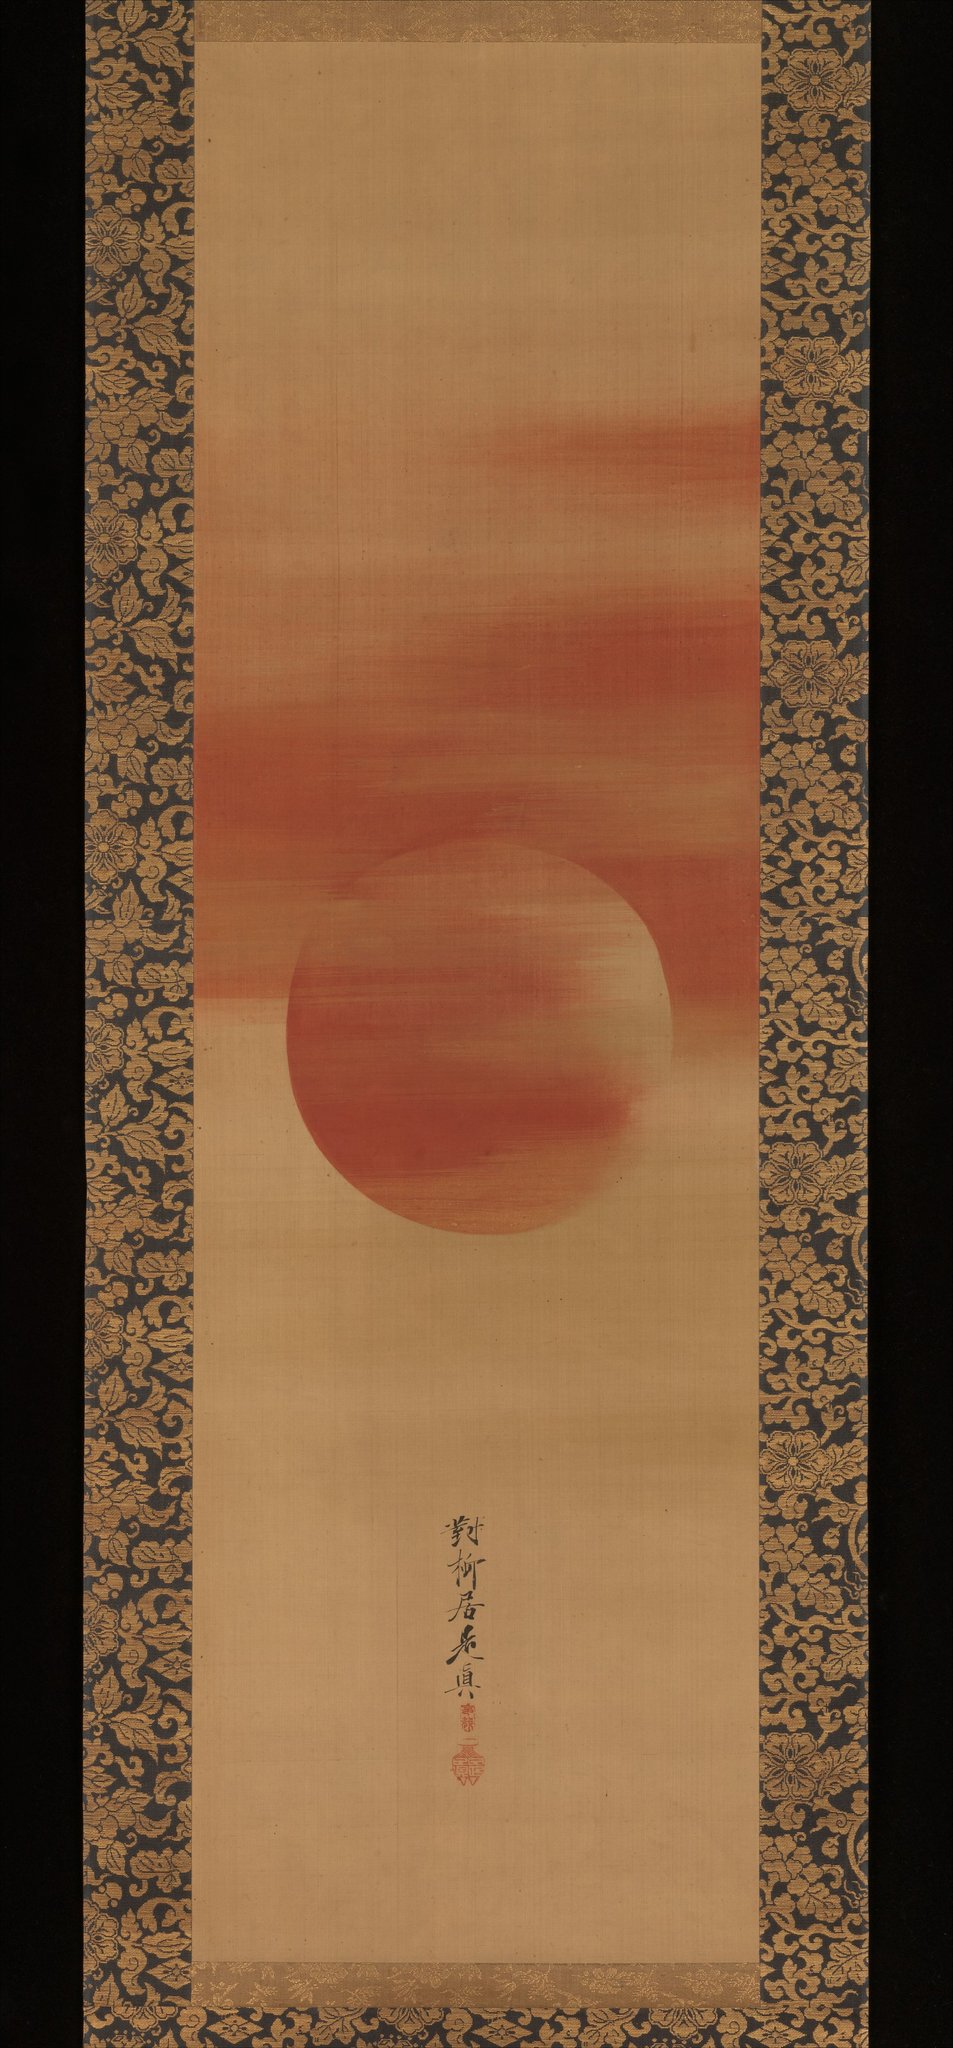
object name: hanging scroll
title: Rising Sun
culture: japanese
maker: shibata zeshin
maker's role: artist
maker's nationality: japanese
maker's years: 1807-1891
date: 1851-1900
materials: ink, silk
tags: sun